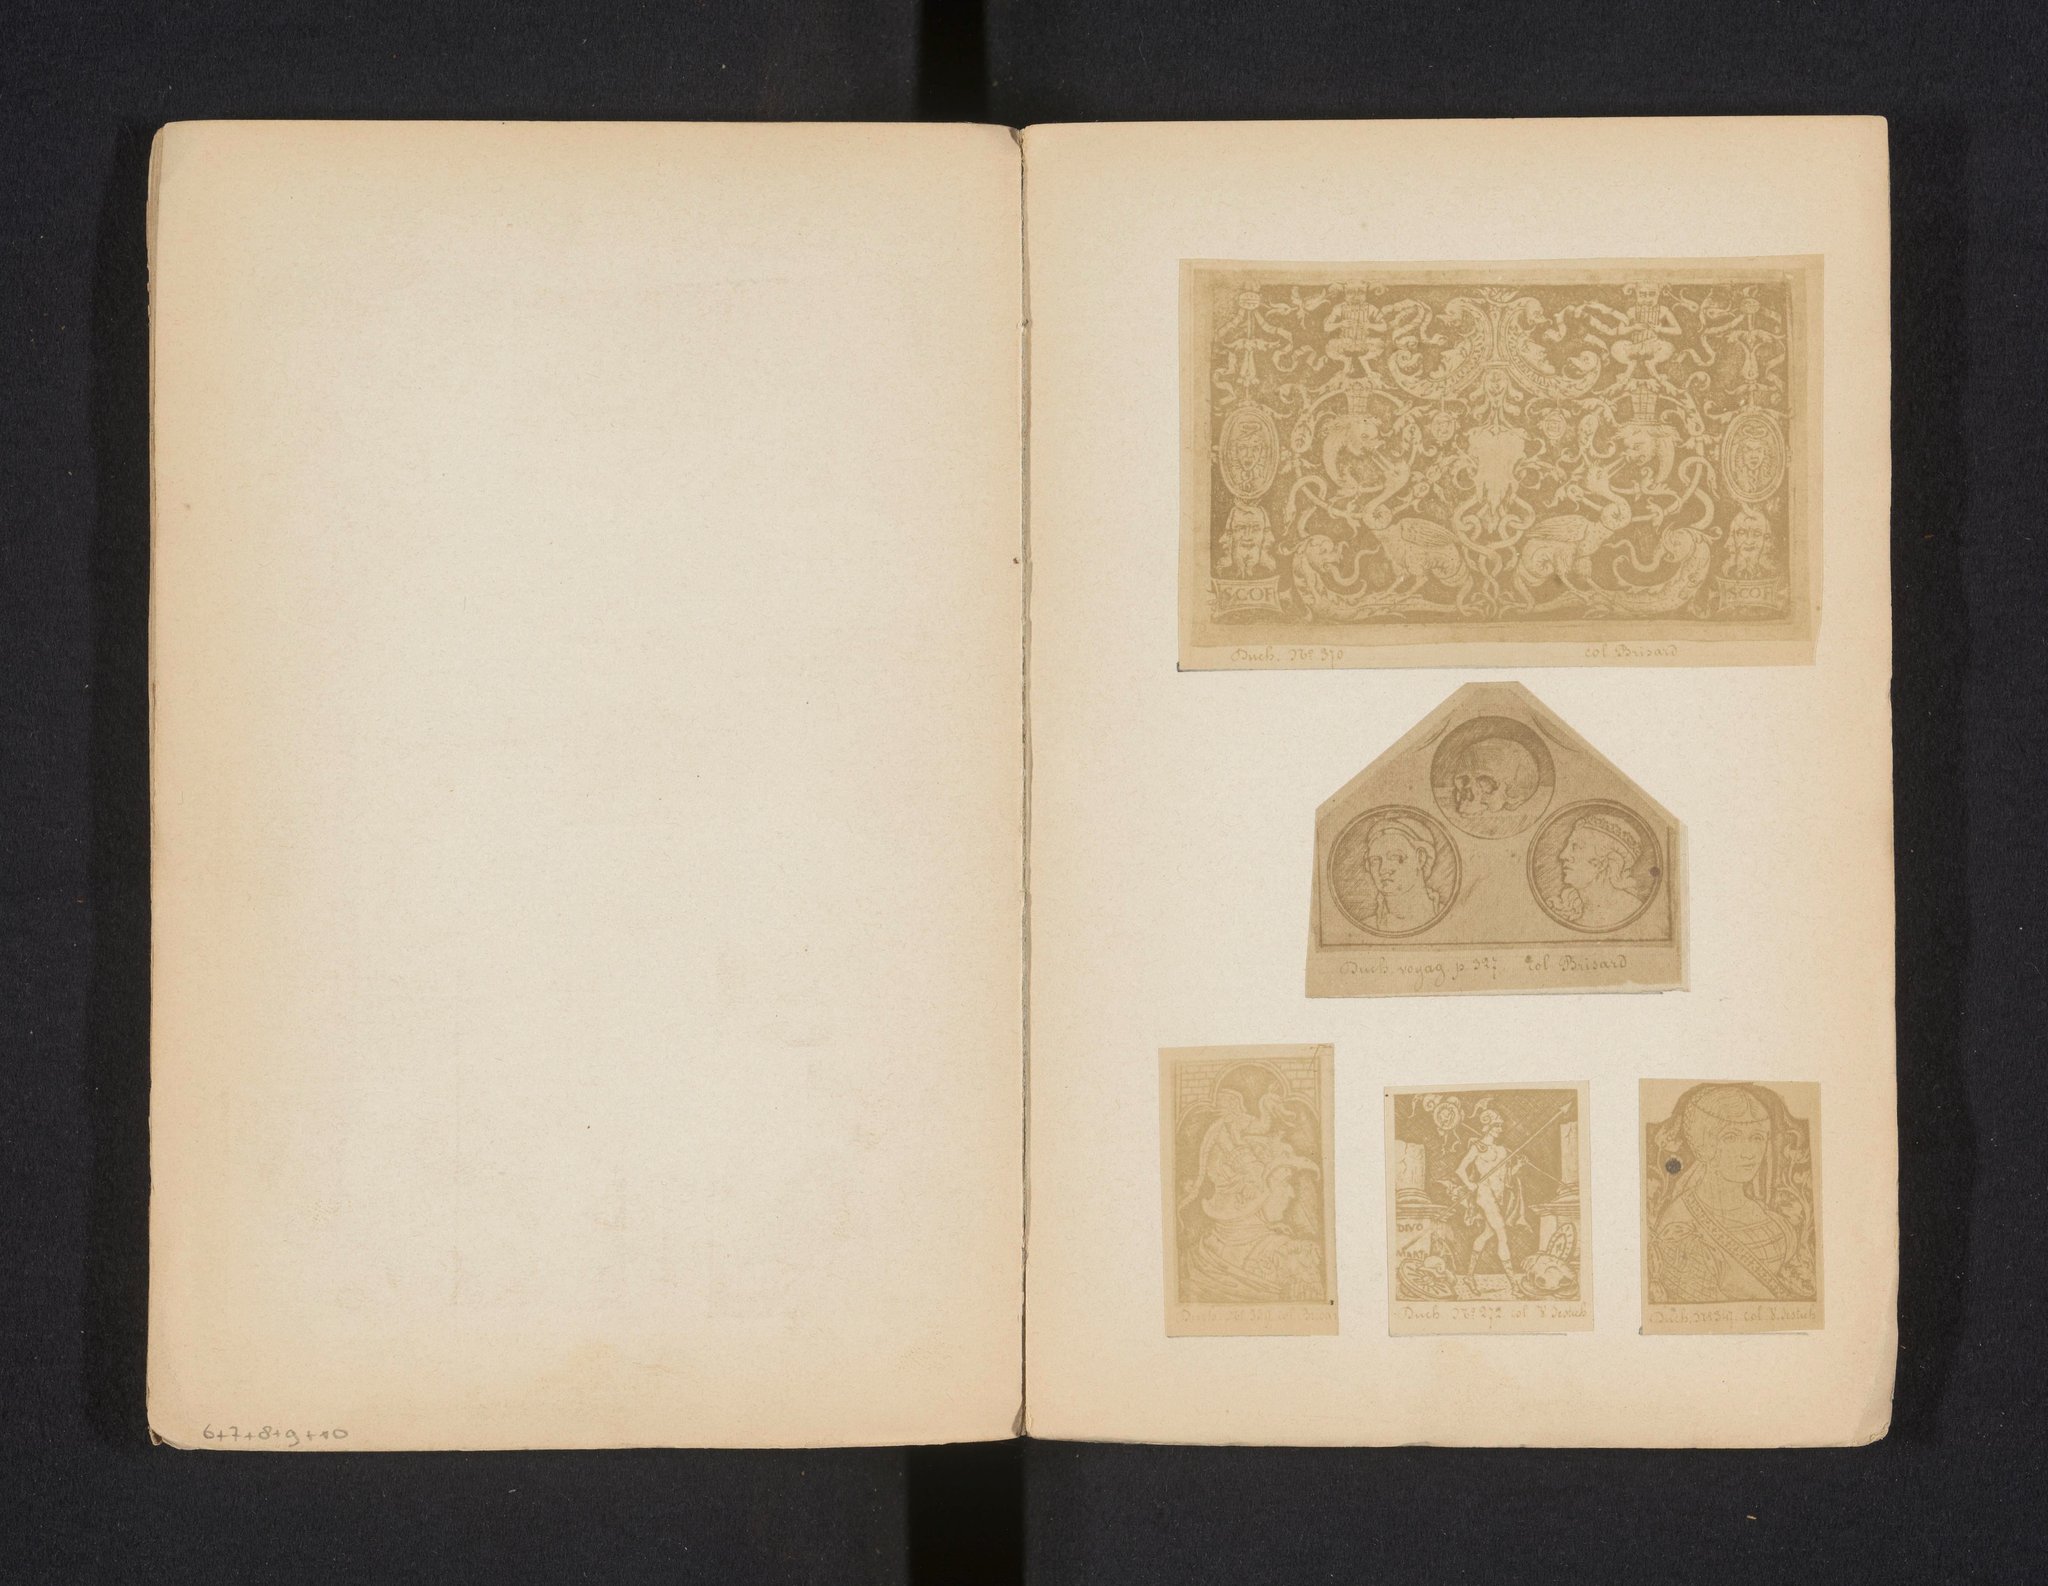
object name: reproduction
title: Fotoreproductie van drie tekeningen, afgebeeld twee gezichten en een schedel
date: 1853-1858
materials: photographic support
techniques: salted paper print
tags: face, (human) skull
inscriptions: inscription: ‘Duch. voyag. p. 327. col. Brisard’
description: Foto op vijfde ongenummerde pagina na pagina 142.